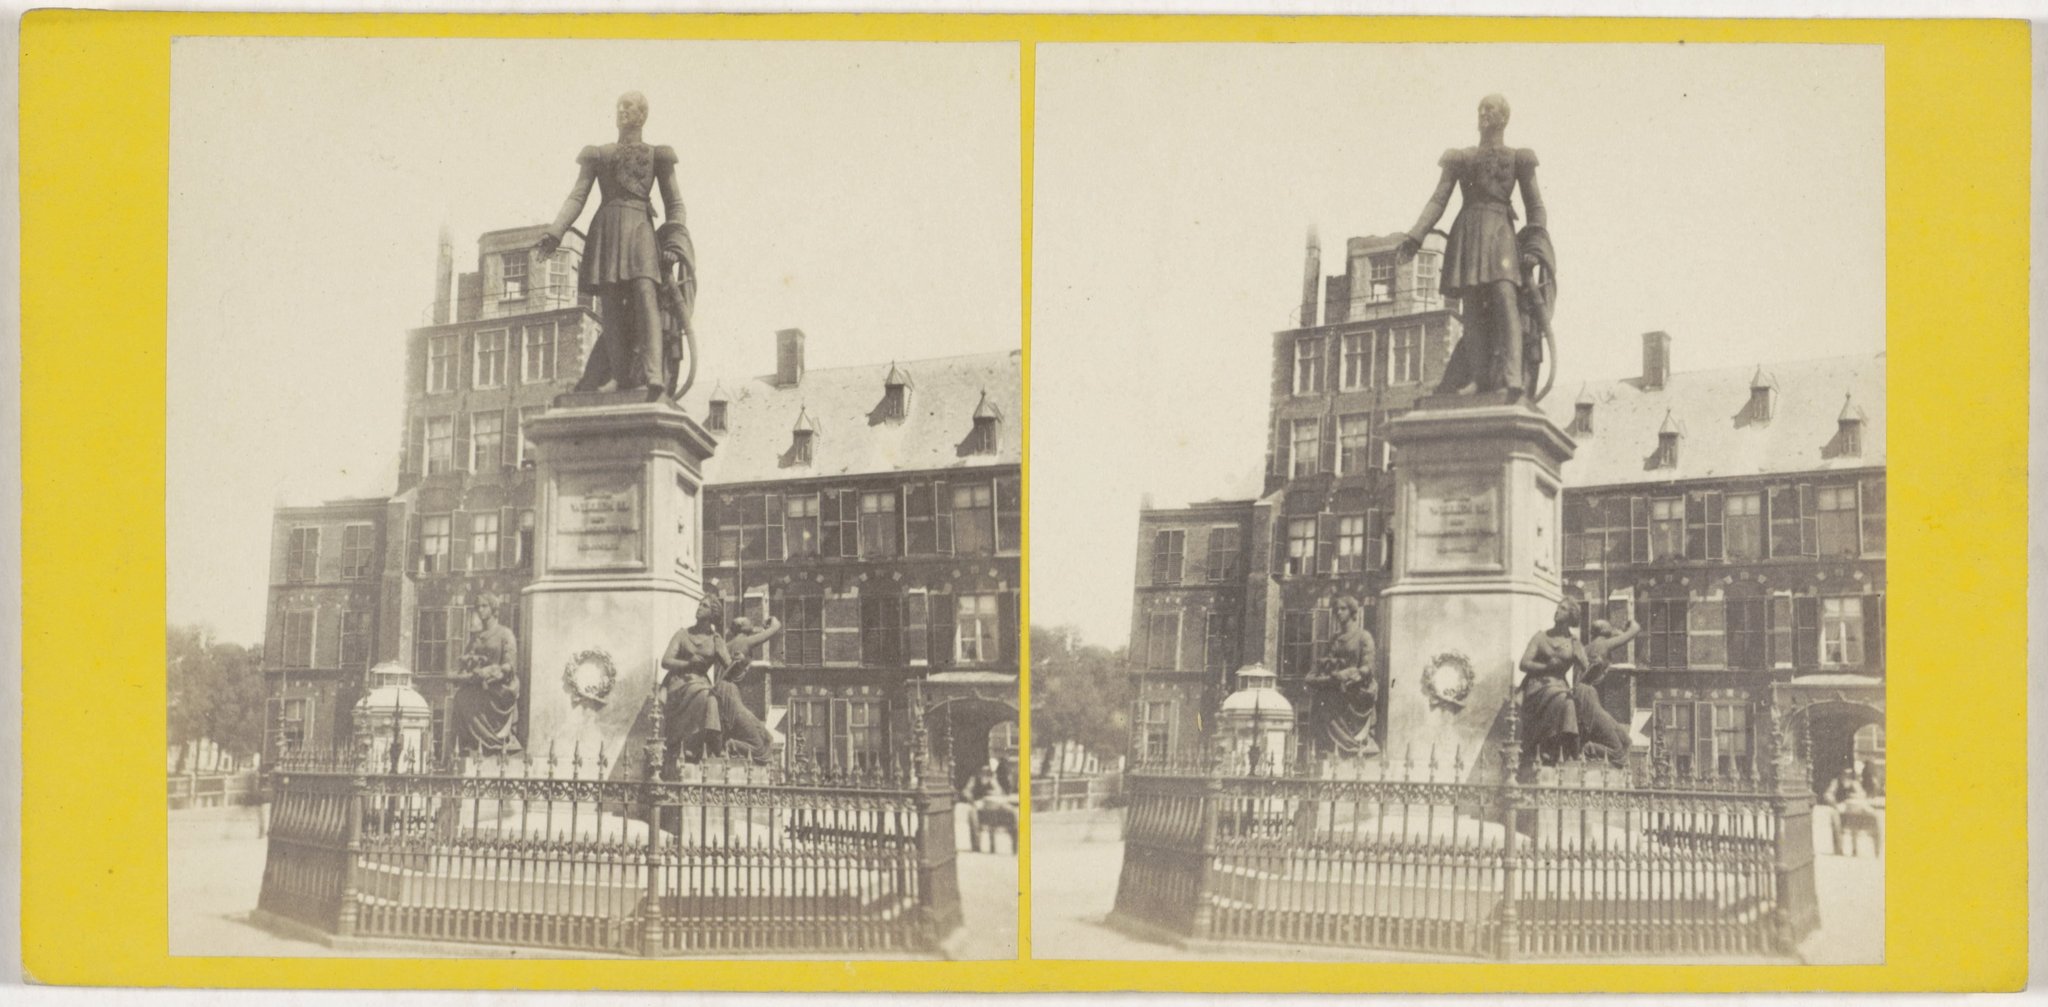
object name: stereograph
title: Gezicht op het standbeeld van Willem II in Den Haag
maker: Anonymous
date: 1861-1870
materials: cardboard, paper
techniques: albumen print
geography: the hague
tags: william ii of the netherlands, monument, statue